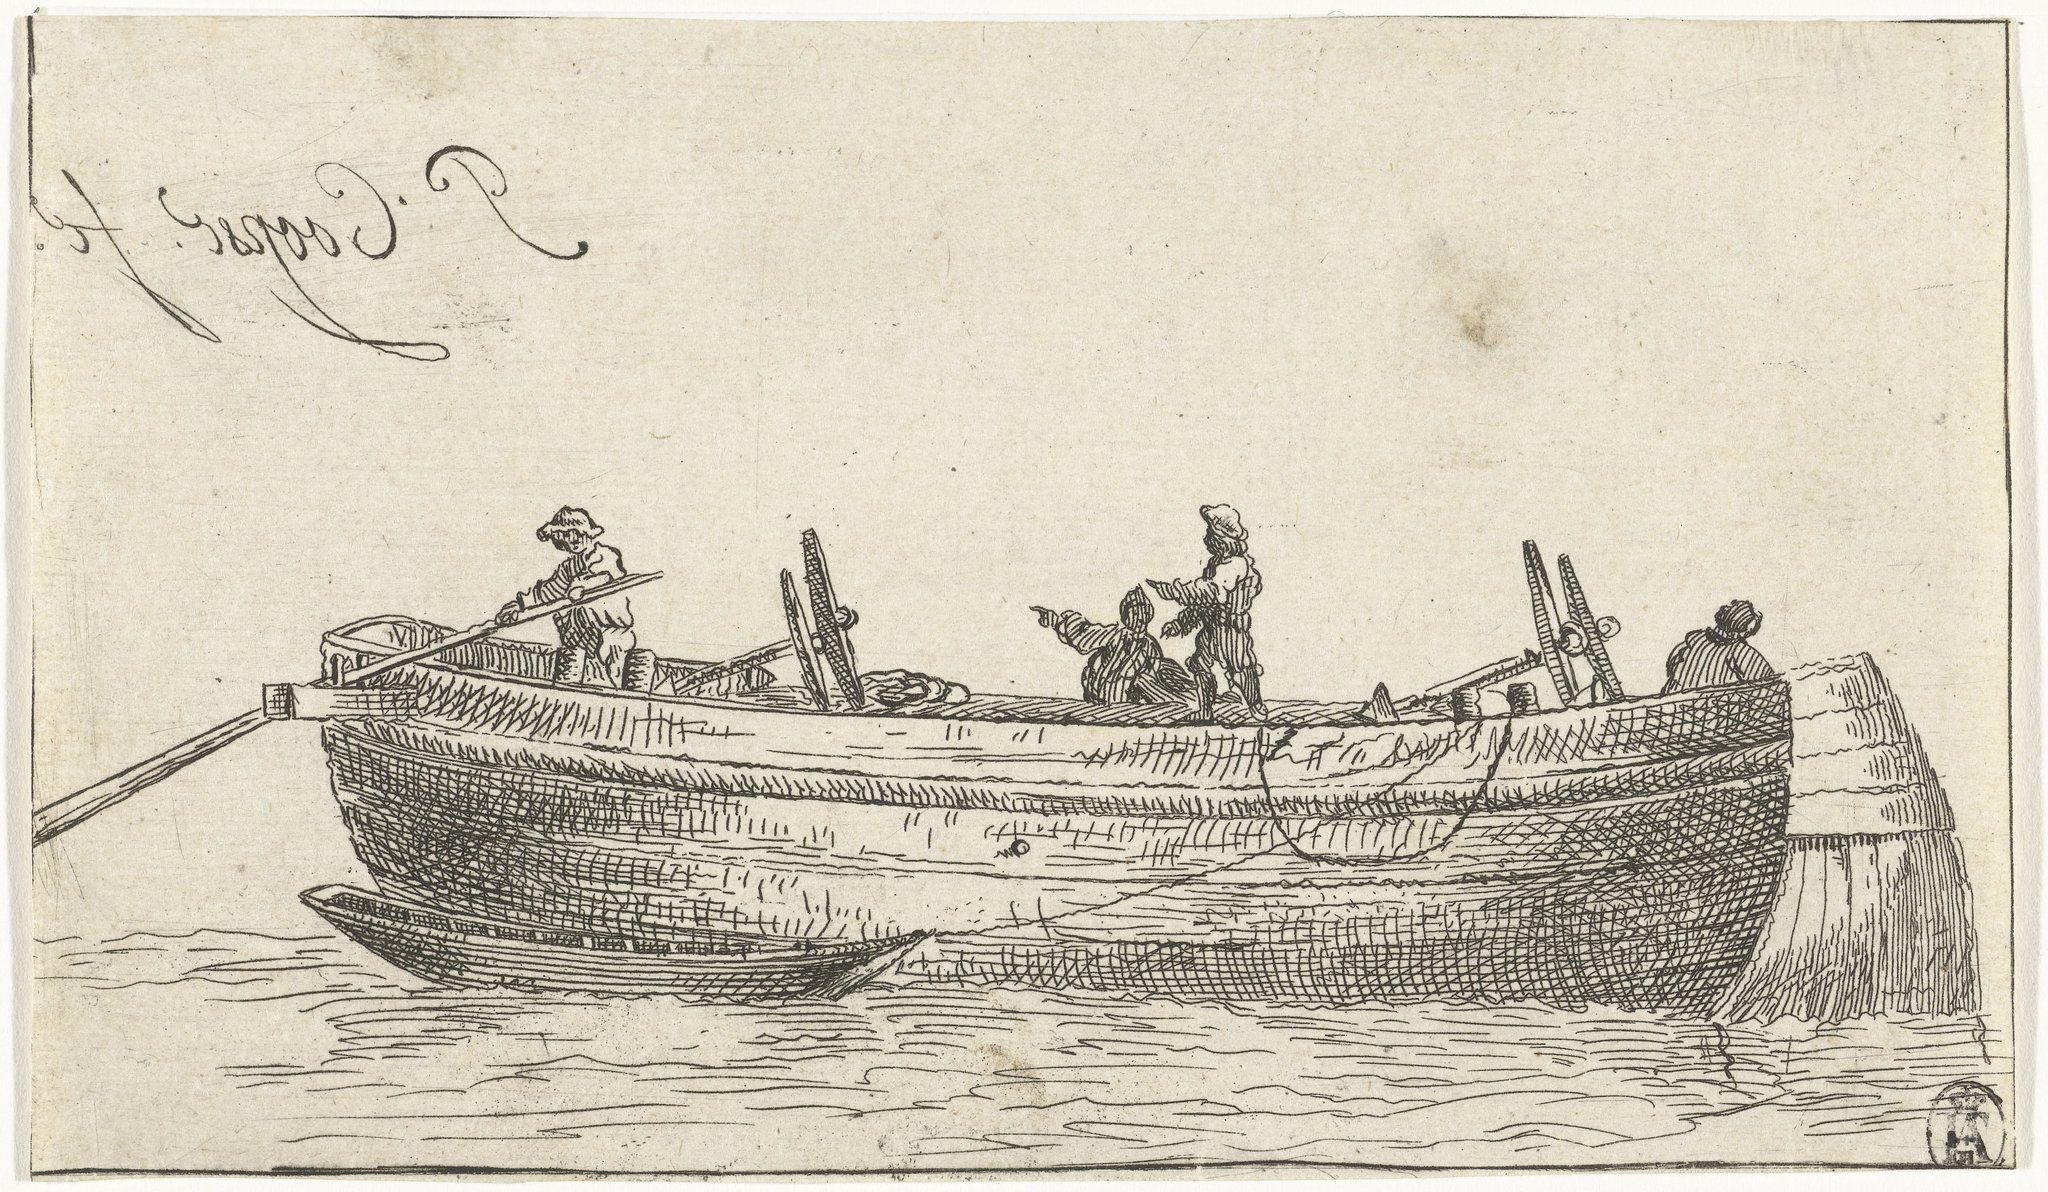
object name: print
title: Vier mannen in een schip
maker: pieter coopse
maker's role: draughtsman, print maker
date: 1650-1675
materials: paper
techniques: etching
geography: amsterdam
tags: boat propelled by man or animal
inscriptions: collector's mark: Lugt 971, collector's mark: Lugt 2228